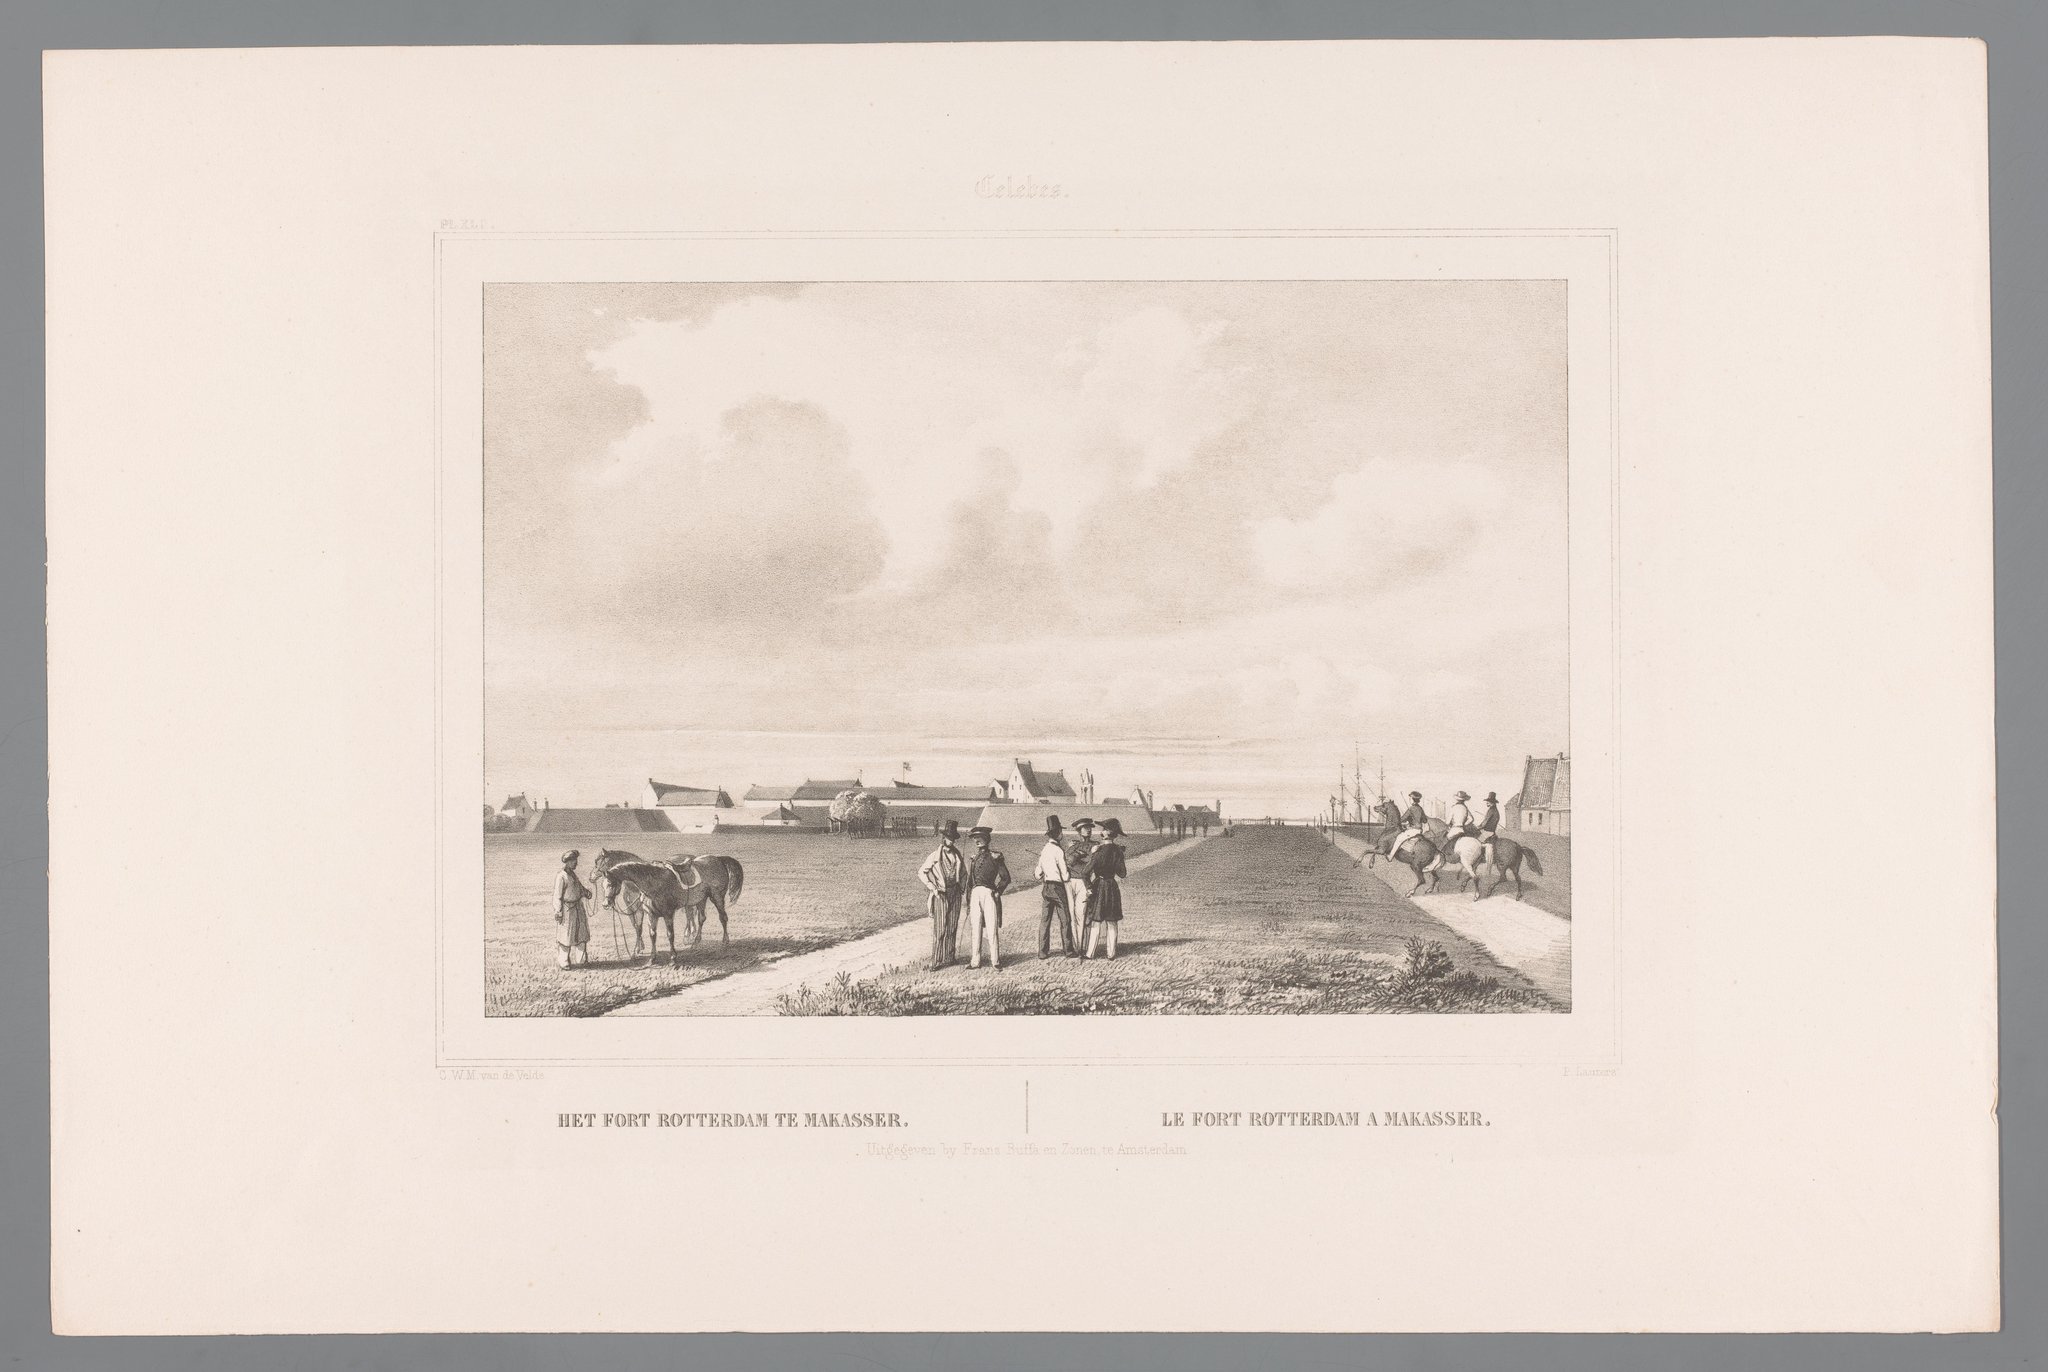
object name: print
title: Gezigten uit Neêrlands Indië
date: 1847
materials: paper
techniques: lithograph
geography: amsterdam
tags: riding a horse, ass, or mule; rider, horseman, fortress, standing figure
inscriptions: collector's mark: Lugt 2228